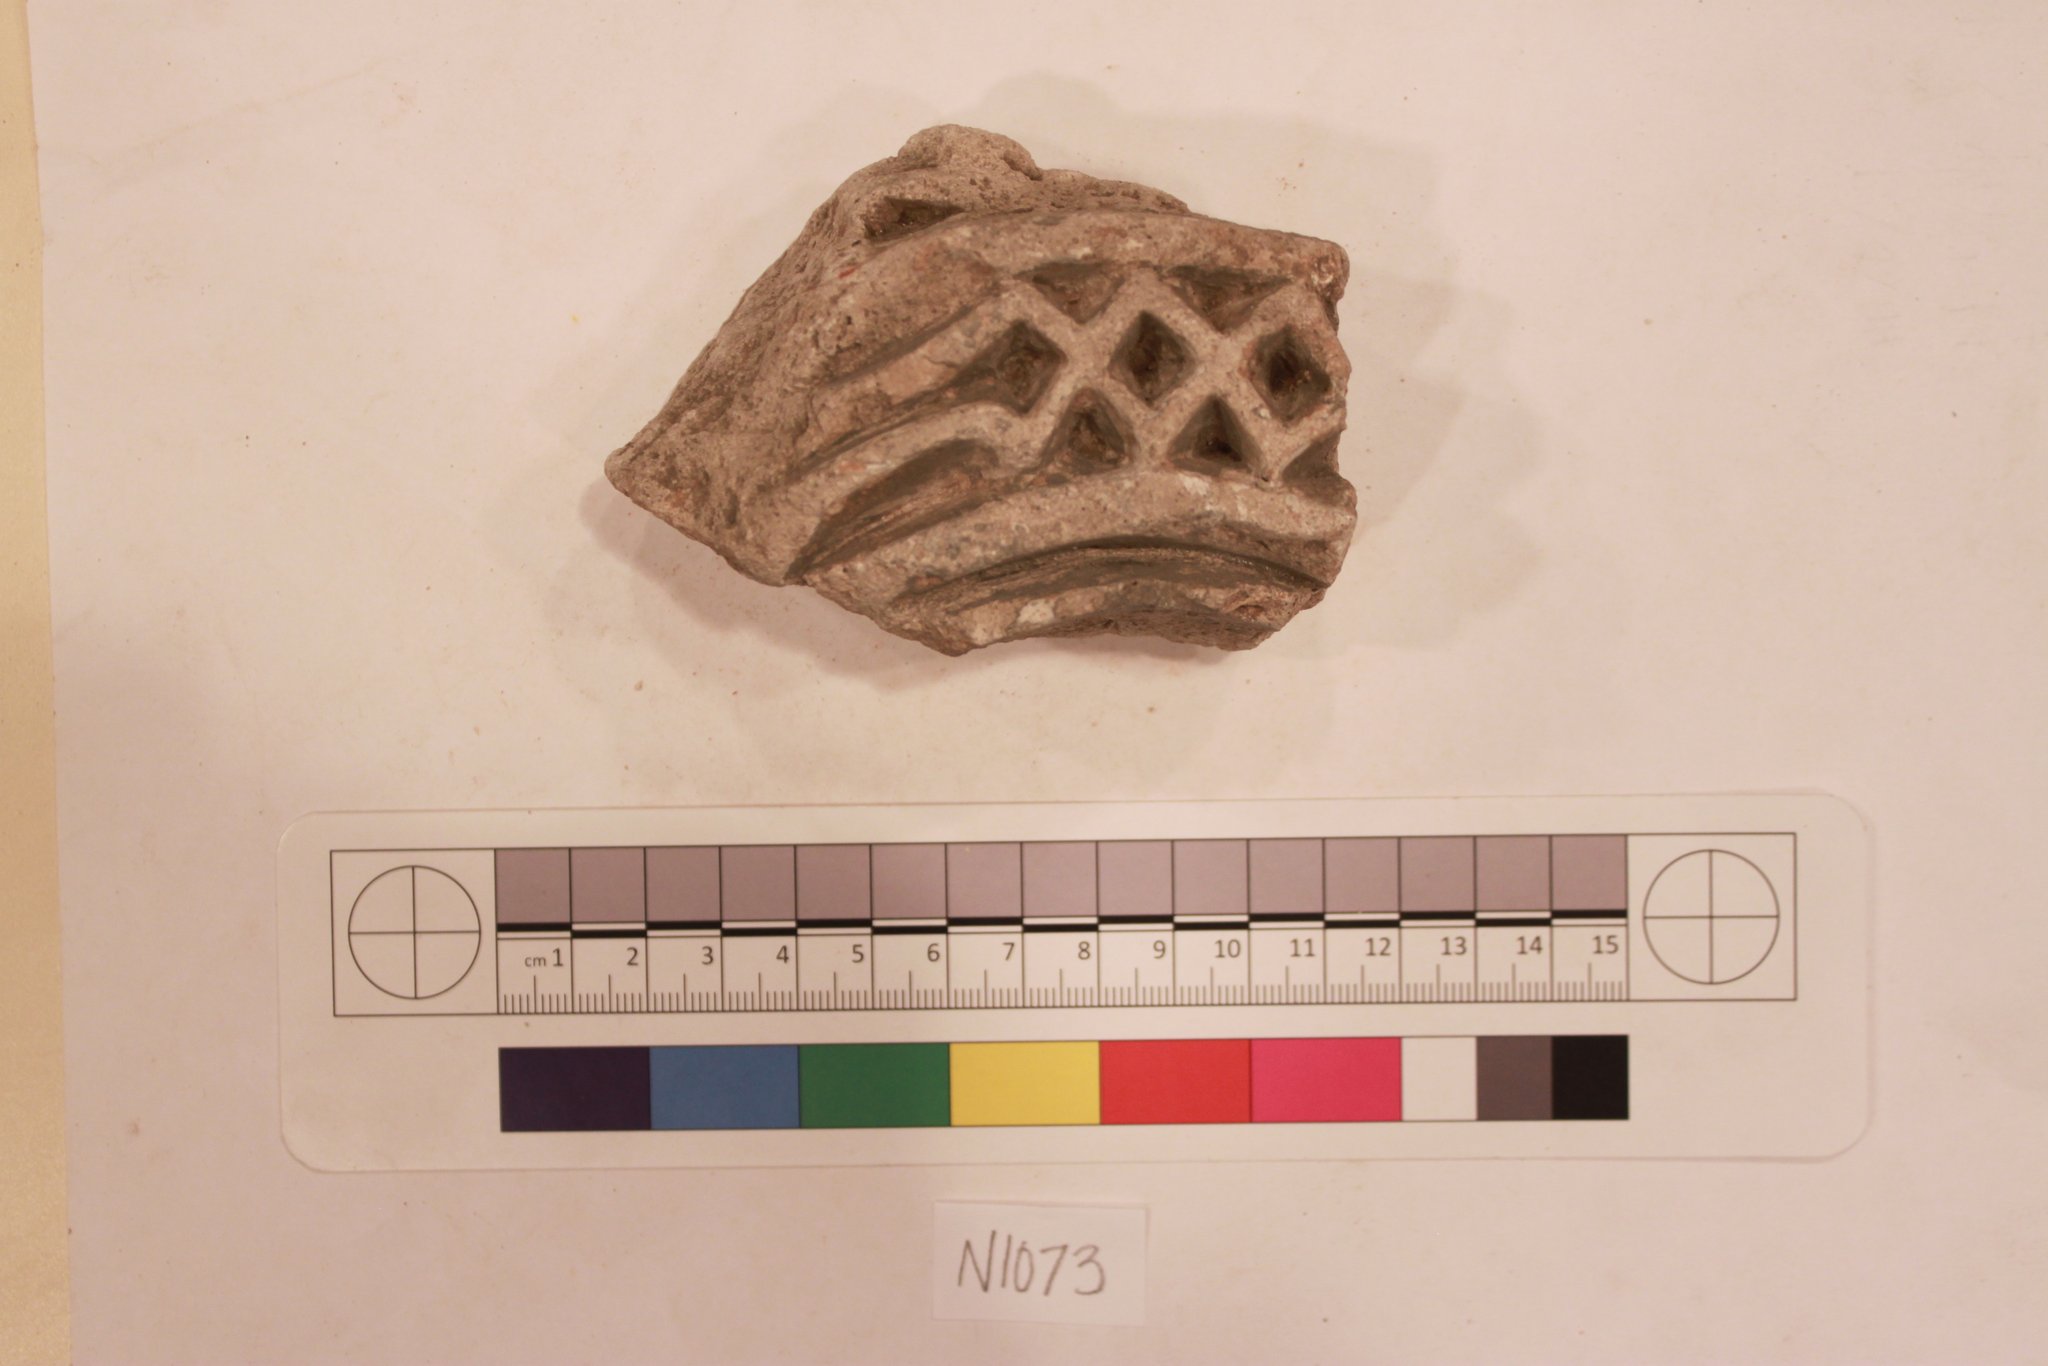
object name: fragment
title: Stucco Fragment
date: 701-1200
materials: plaster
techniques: carving, painting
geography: iran